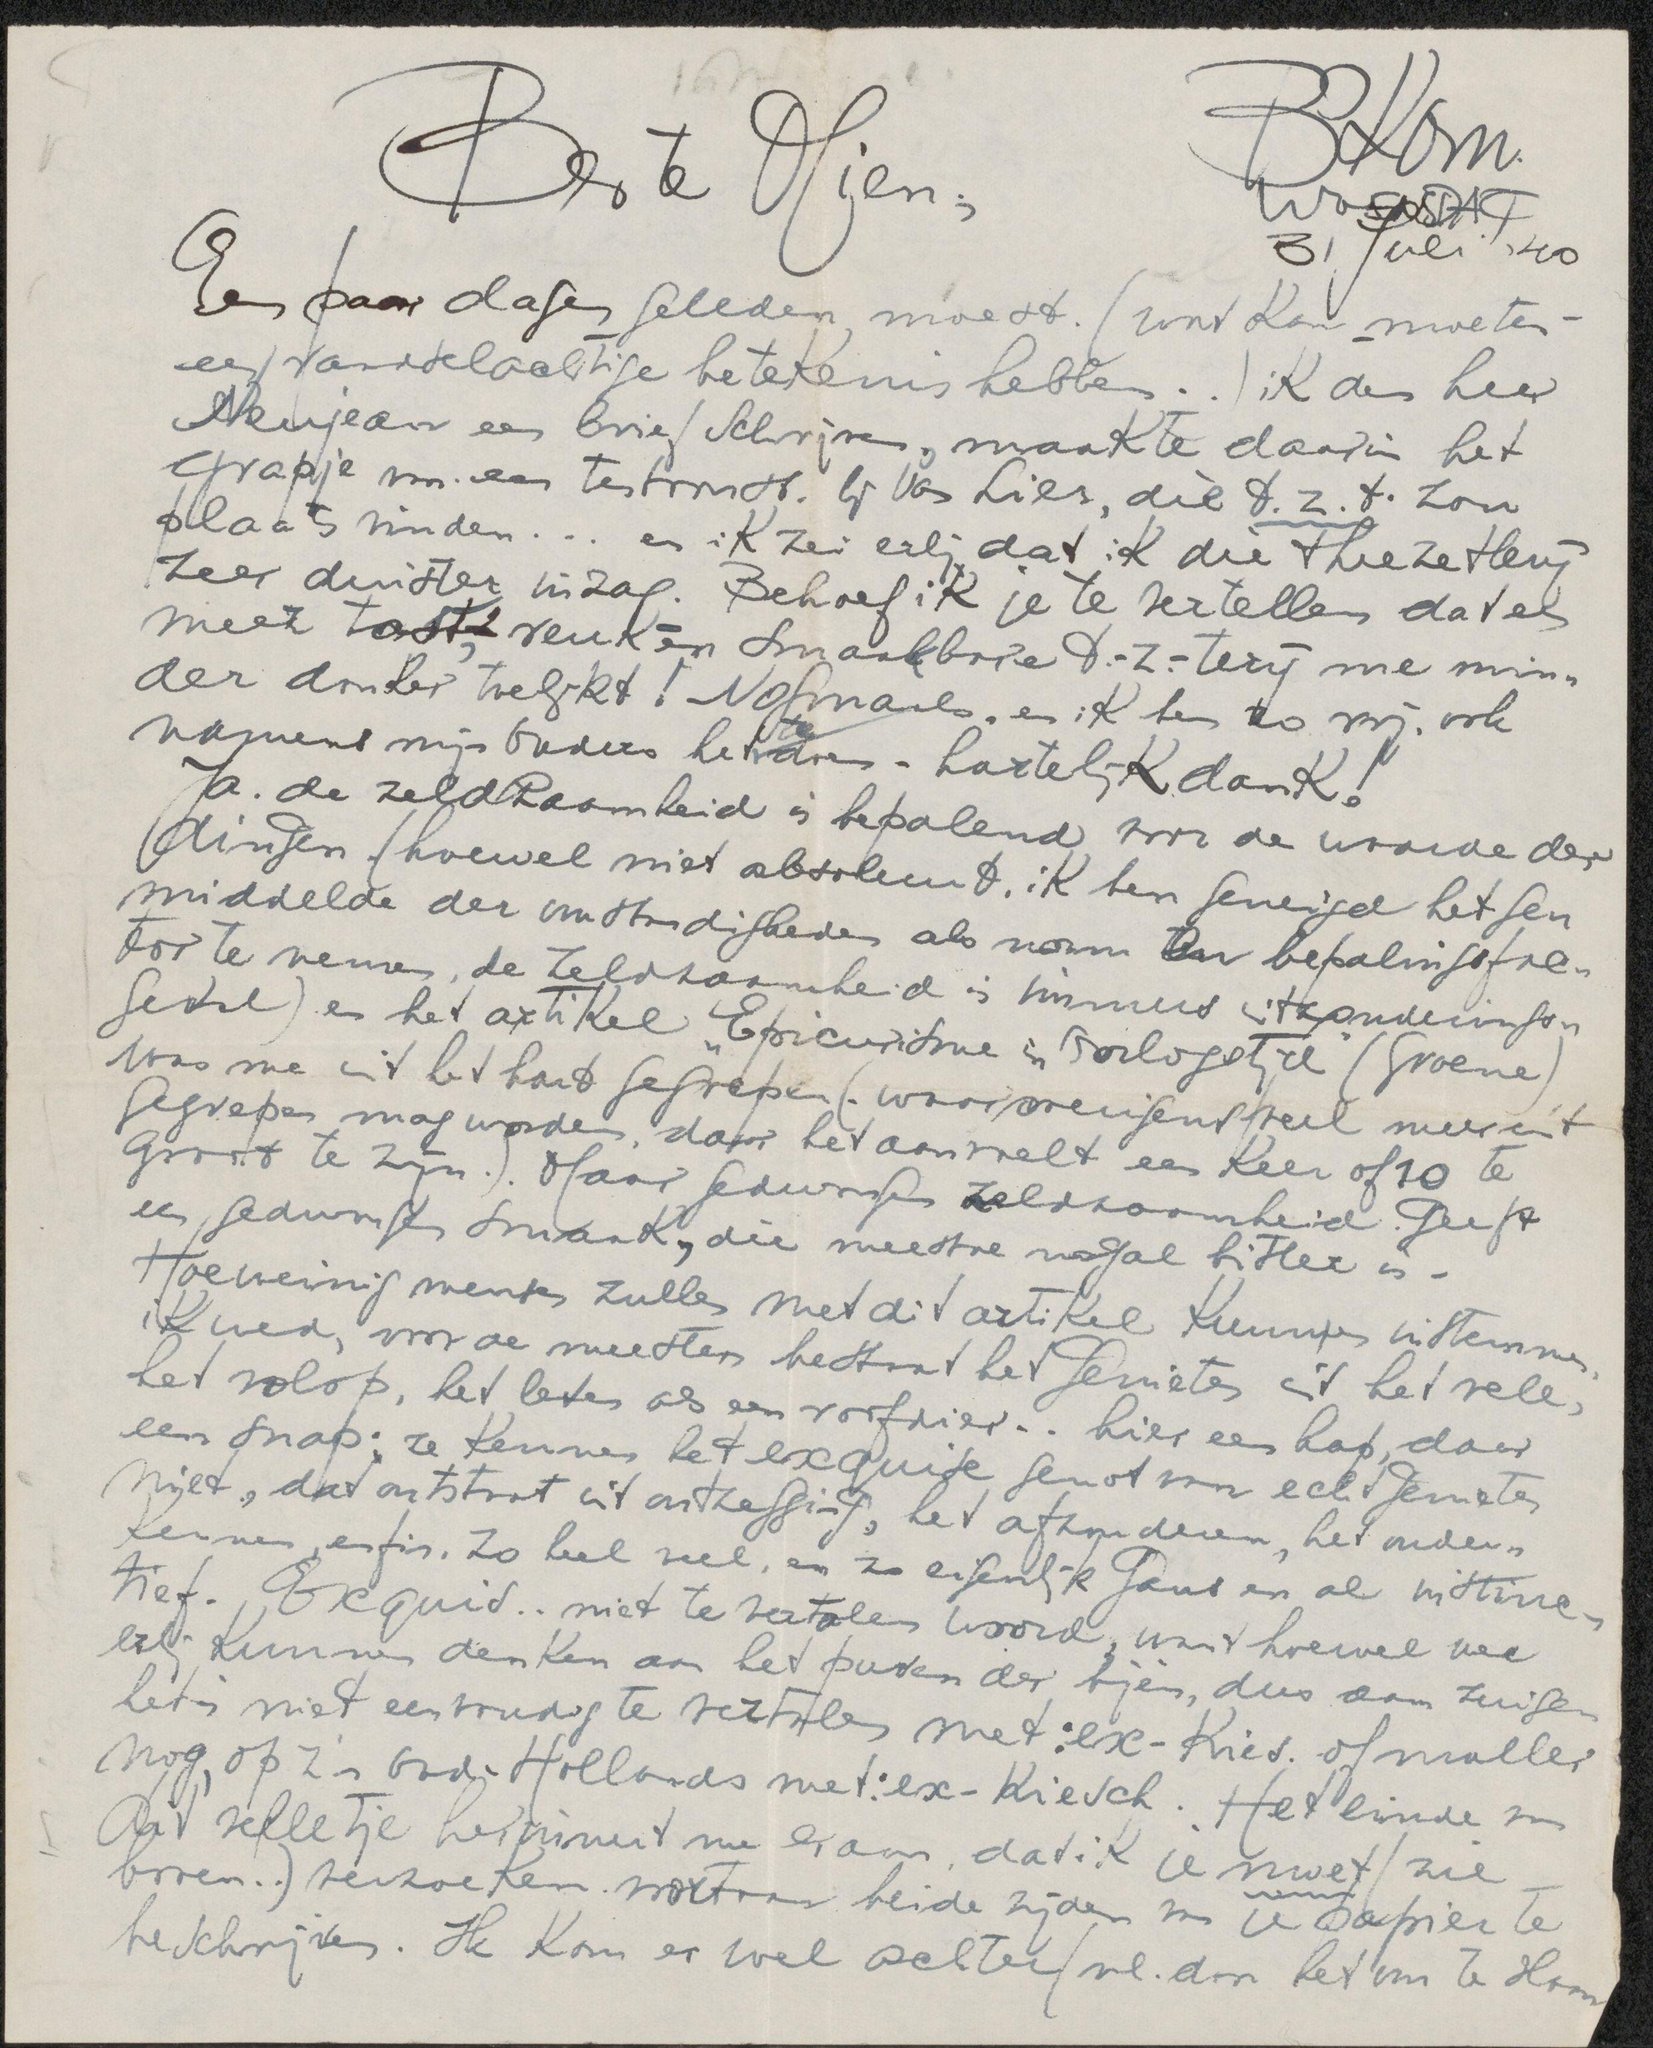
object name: letter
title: Brief aan Mien Cambier van Nooten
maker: dick ket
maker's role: draughtsman, print maker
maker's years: 1902-1940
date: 1940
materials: ink, paper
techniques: pen, writing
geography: bennekom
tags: mien cambier van nooten, draughtsman, arnold b. neujean, dollmaker, textile artist, nelly johanna hagelen-schilt, exhibition ~ art, historical persons (portraits and scenes from the life)